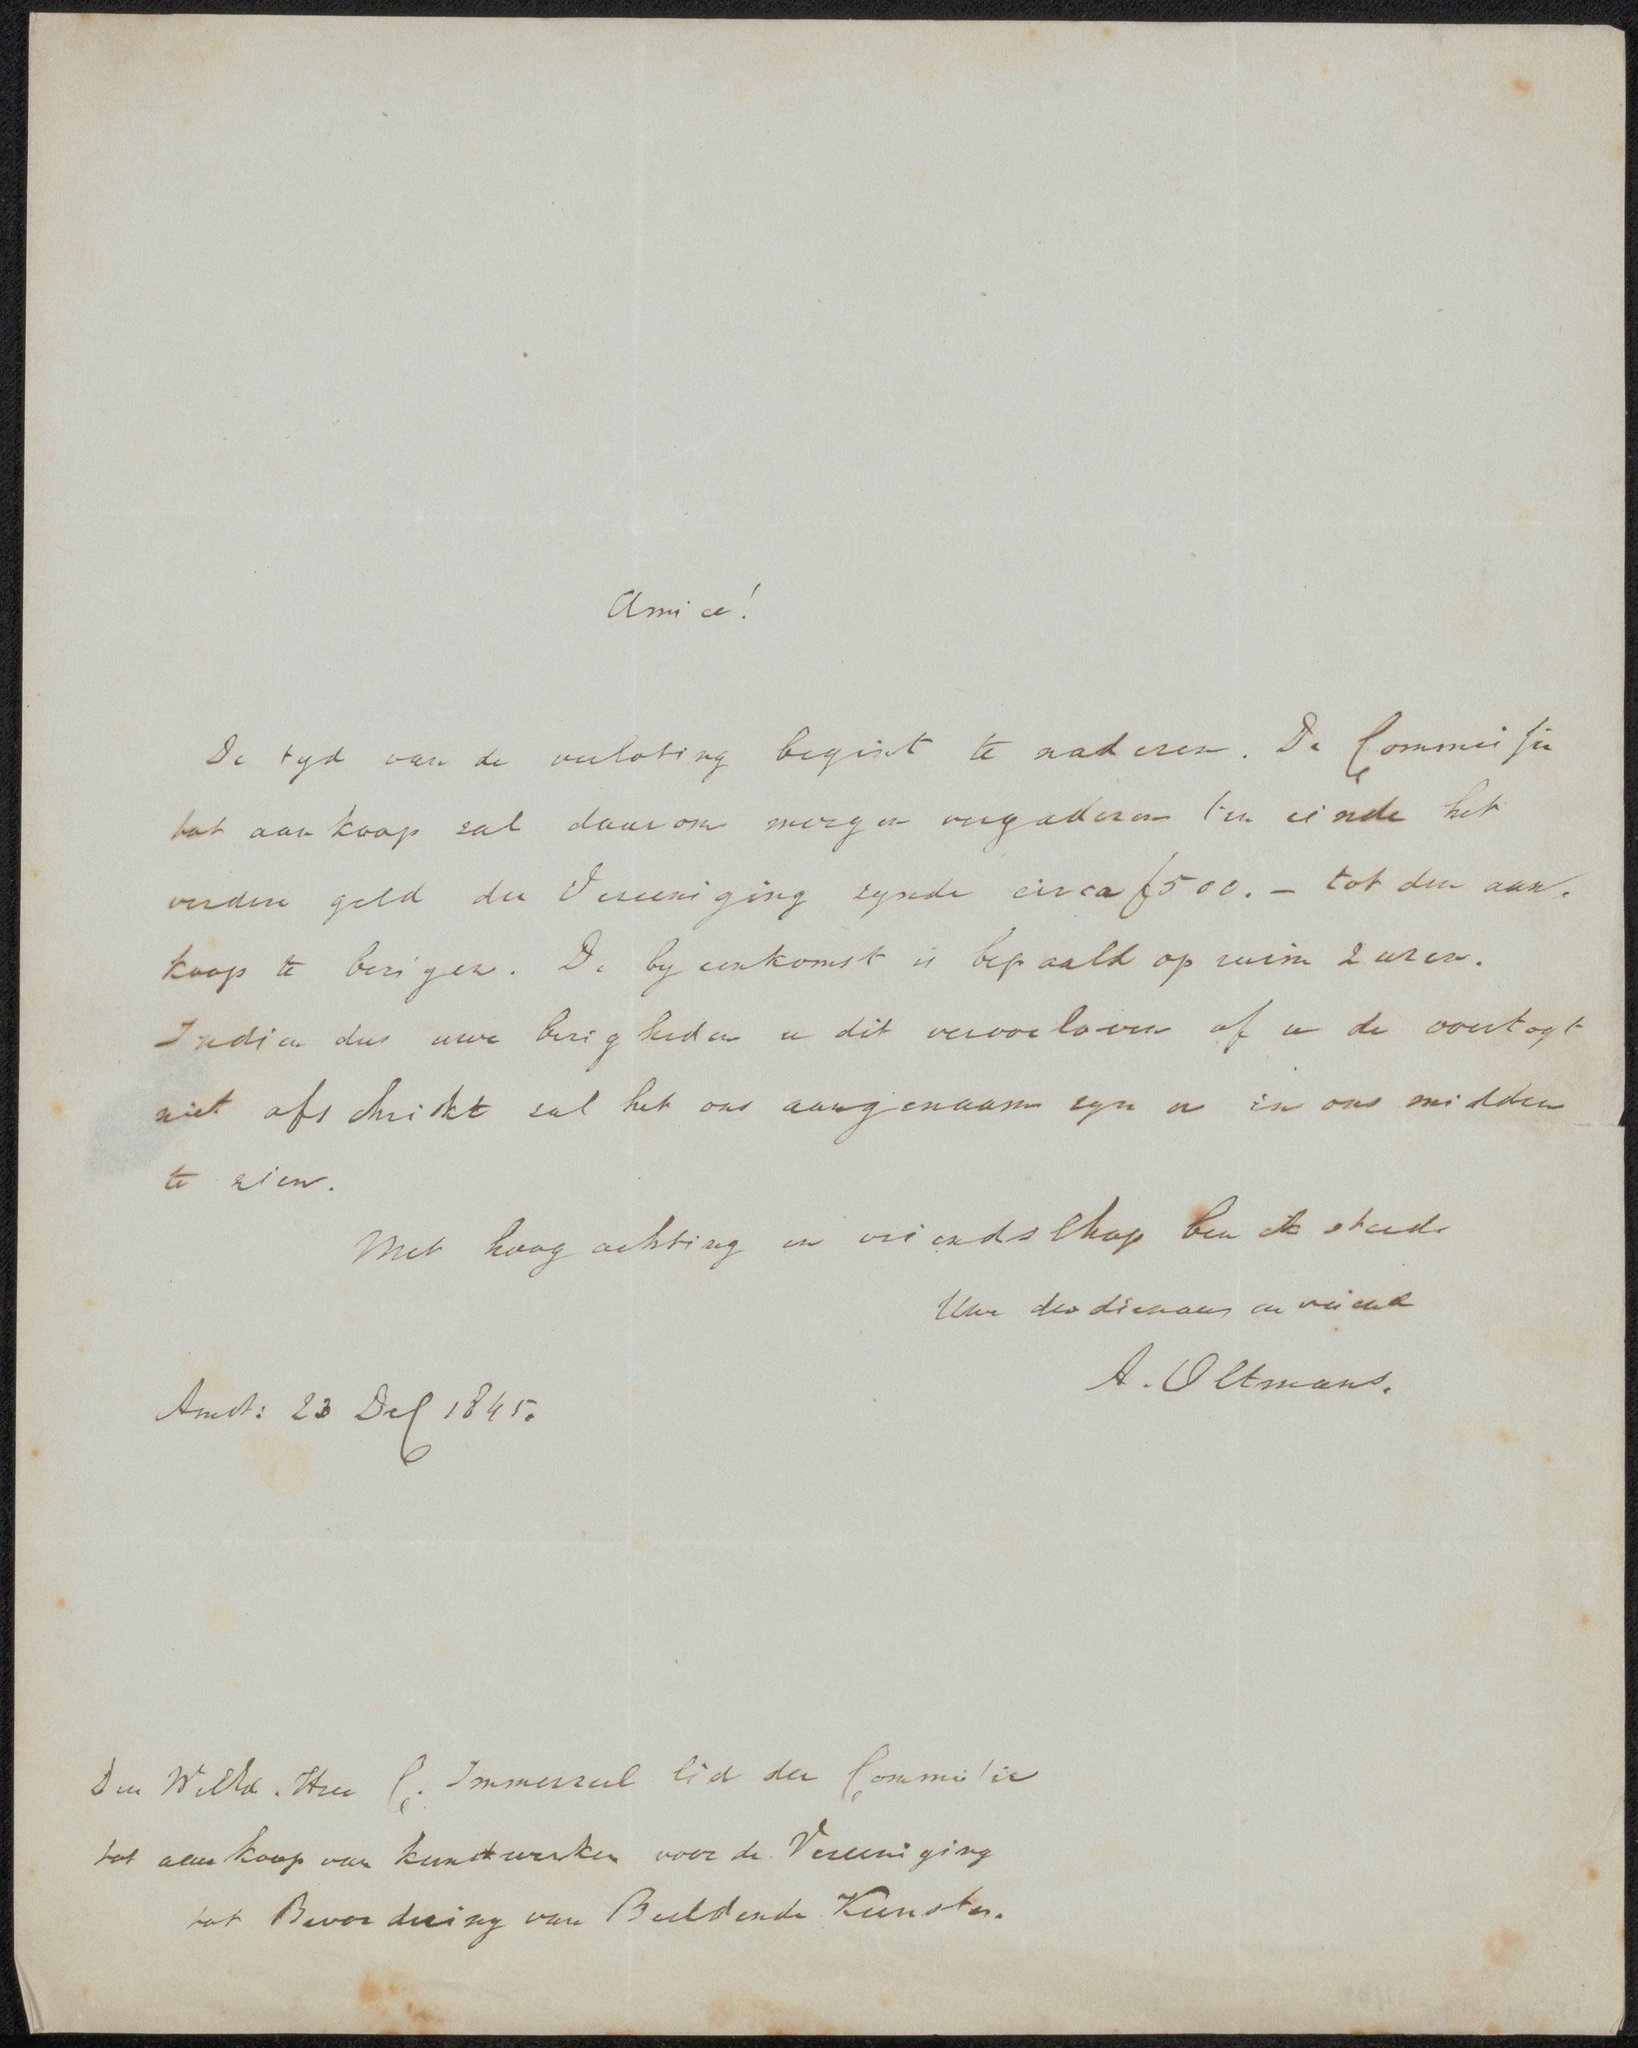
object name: letter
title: Brief aan Christiaan Immerzeel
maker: alexander oltmans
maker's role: draughtsman, print maker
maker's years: 1814-1853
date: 1845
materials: ink, paper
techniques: pen, writing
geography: amsterdam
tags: the hague, christiaan immerzeel, charitable works, money